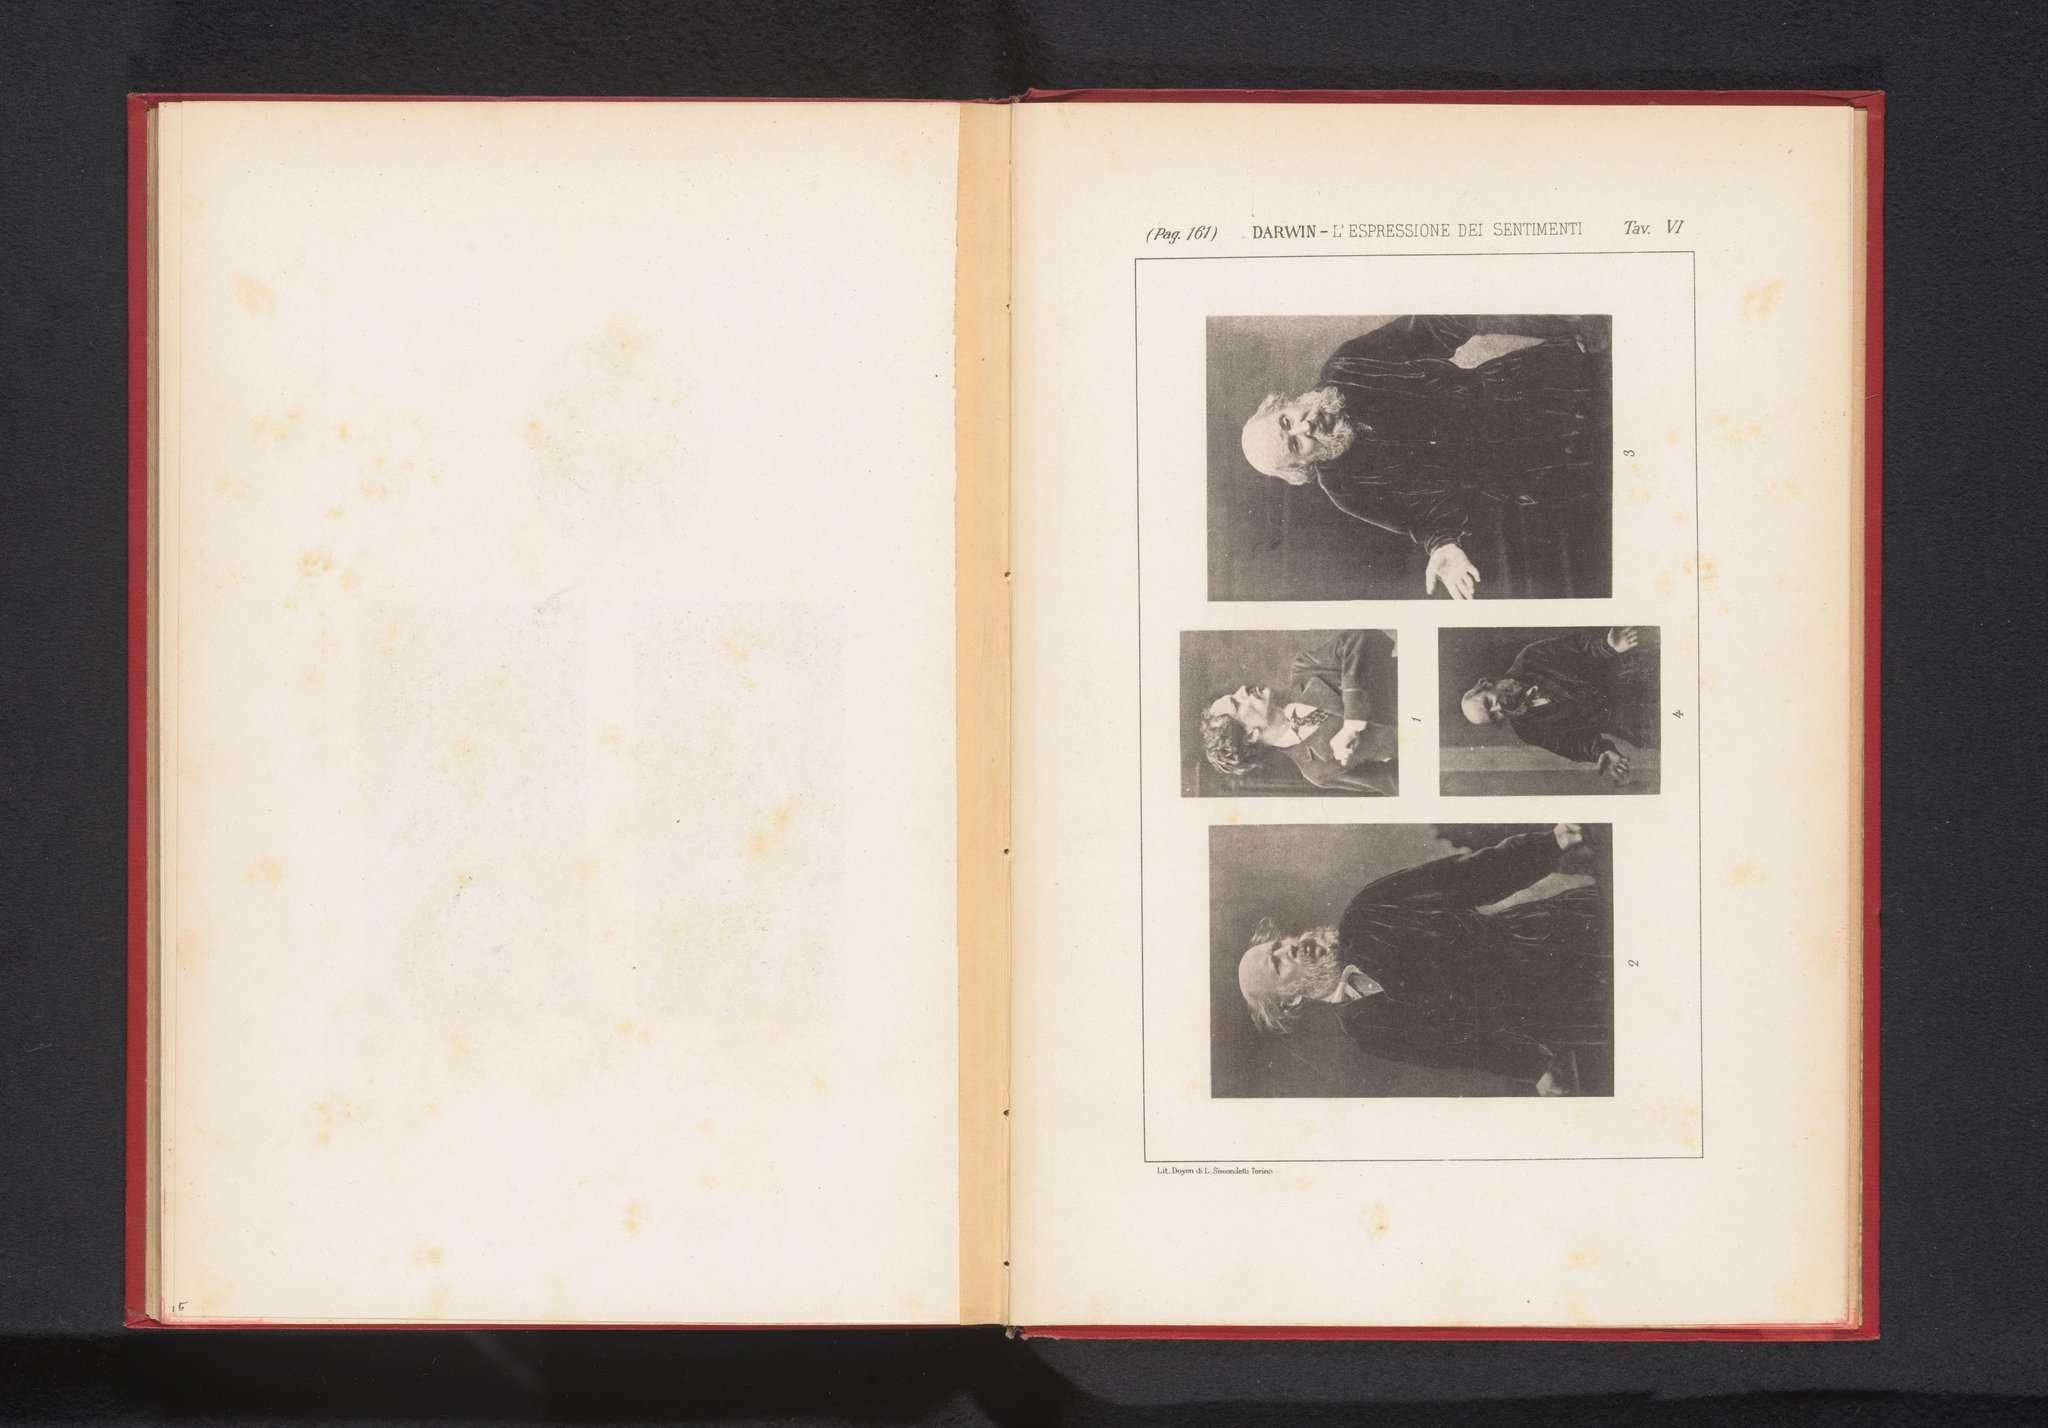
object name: page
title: Vier portretten van onbekende mannen die vermoedelijk hulpeloosheid tonen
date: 1880-1890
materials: paper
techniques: photograph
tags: passions, emotions, affections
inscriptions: number: ‘Tav. VI 1 2 3 4 (Pag. 161)’